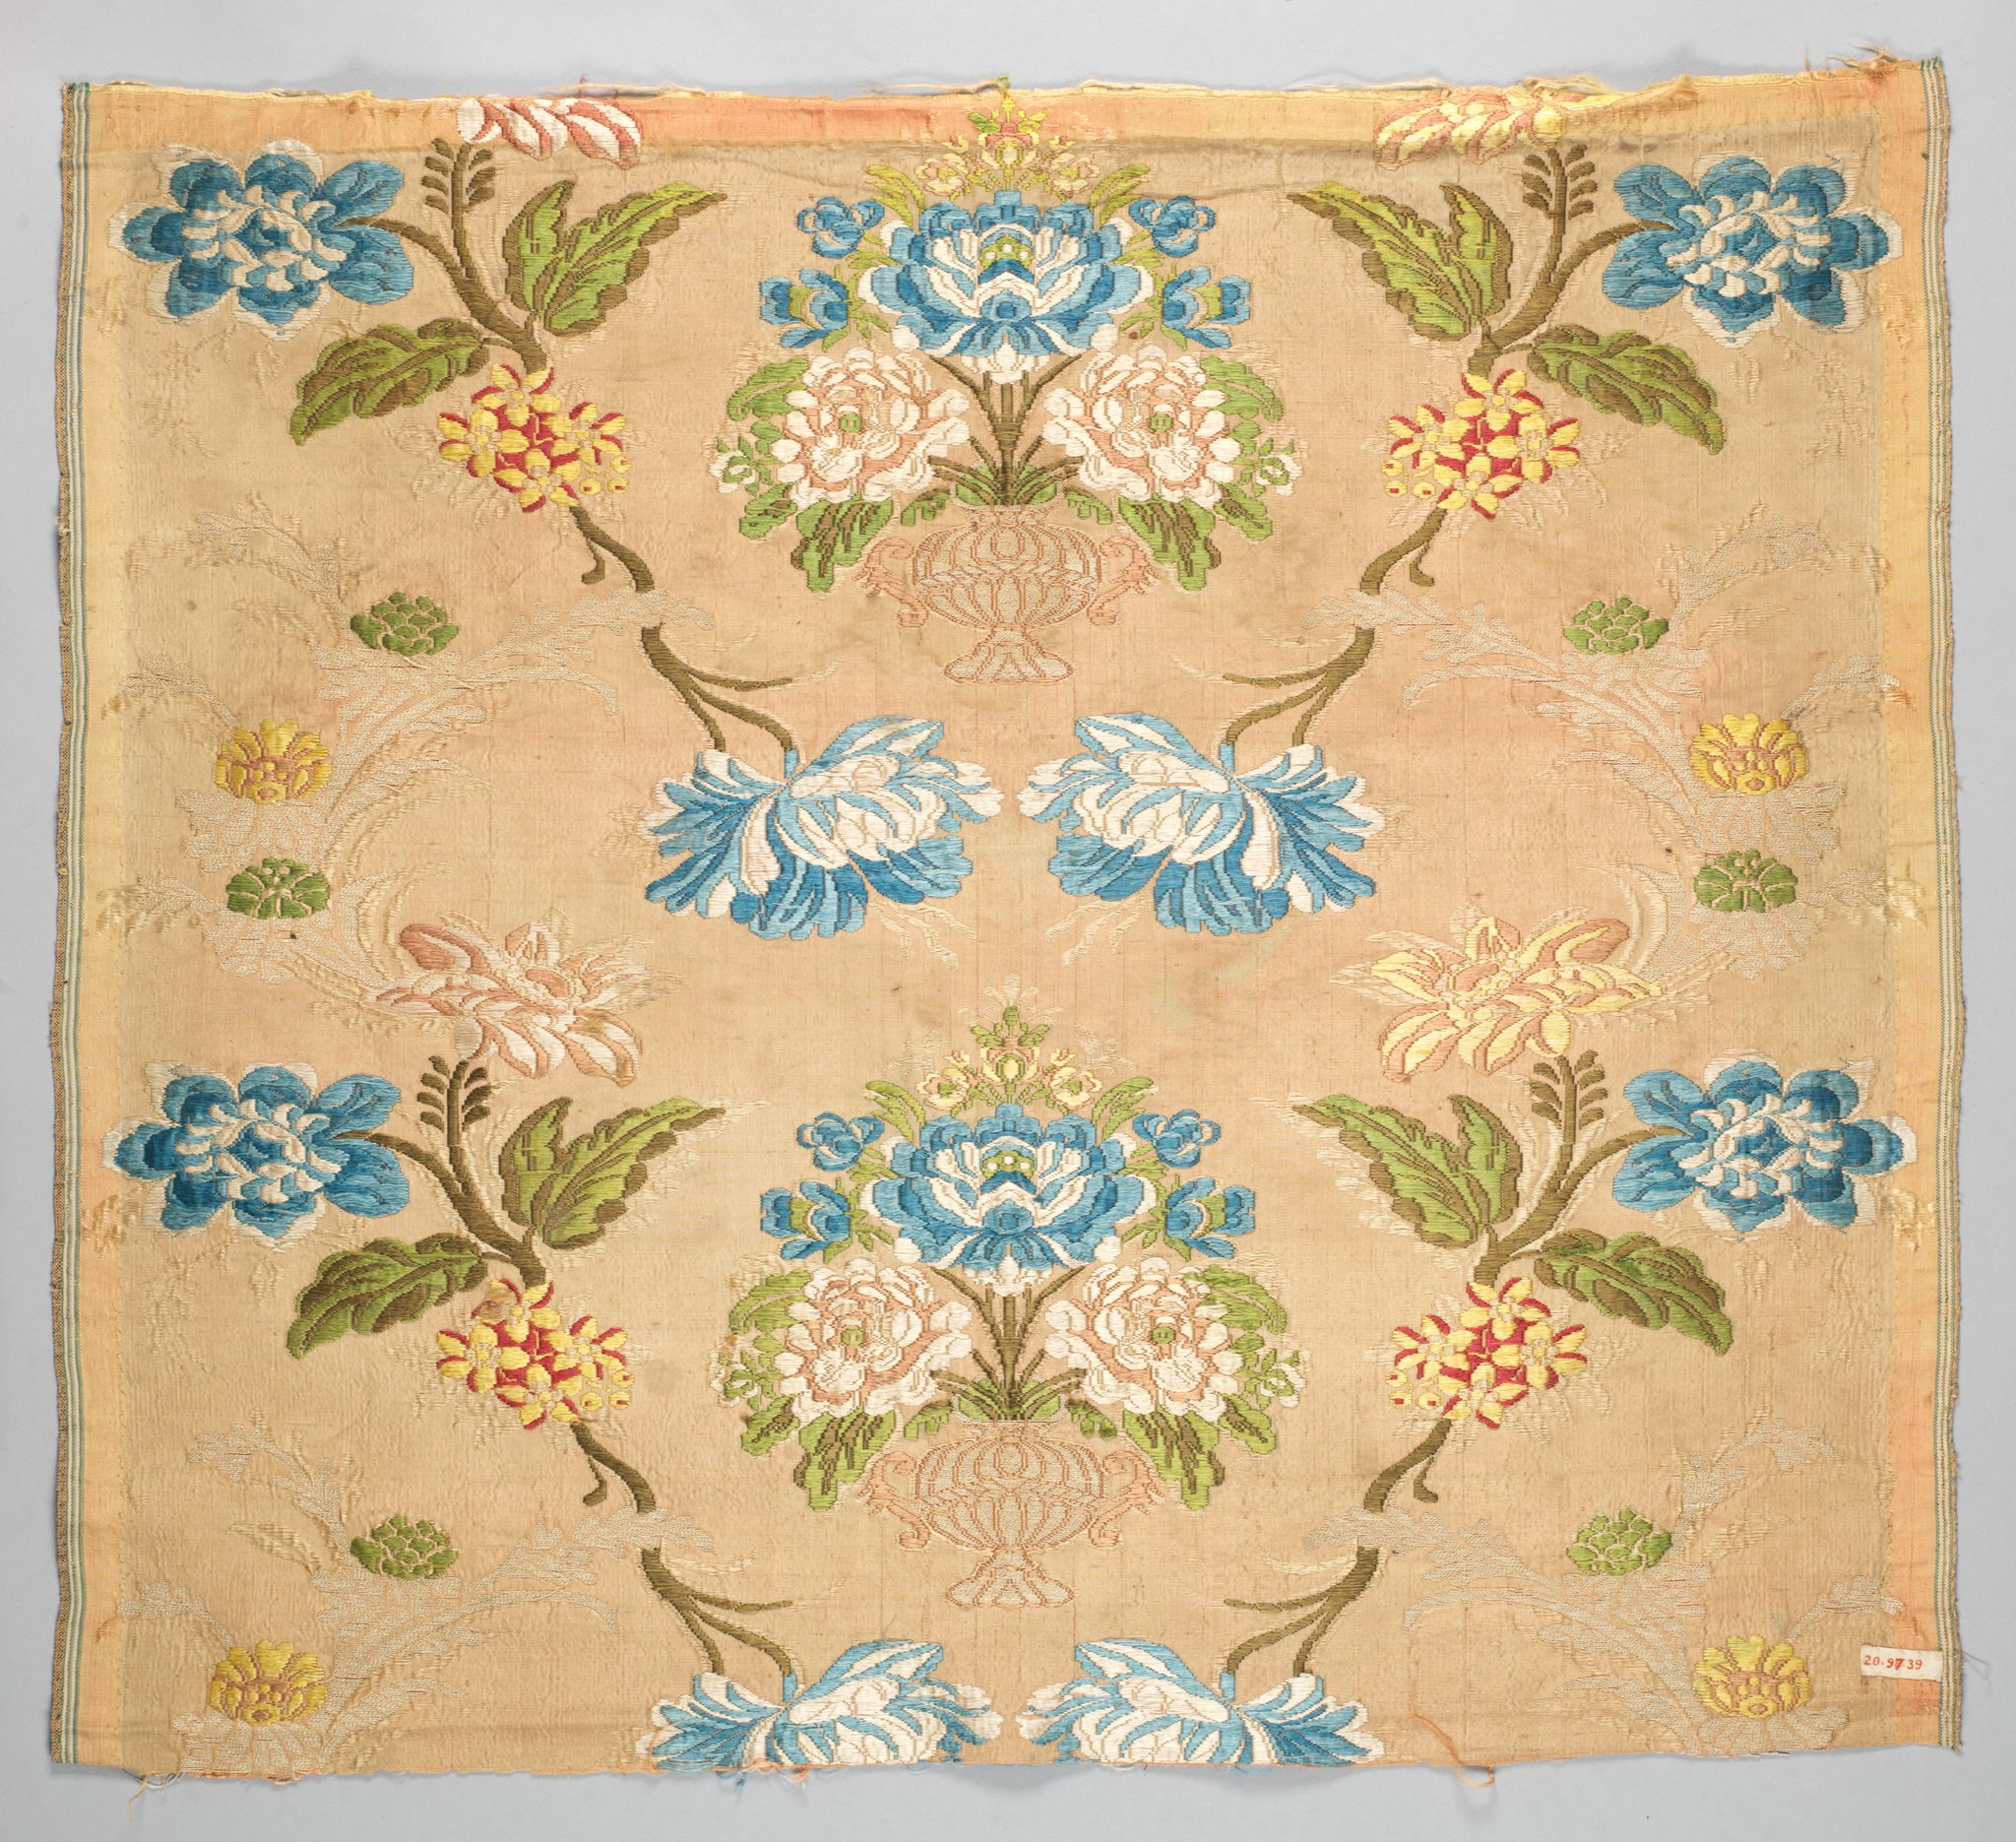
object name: silk weave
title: Furnishing silk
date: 1750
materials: silk